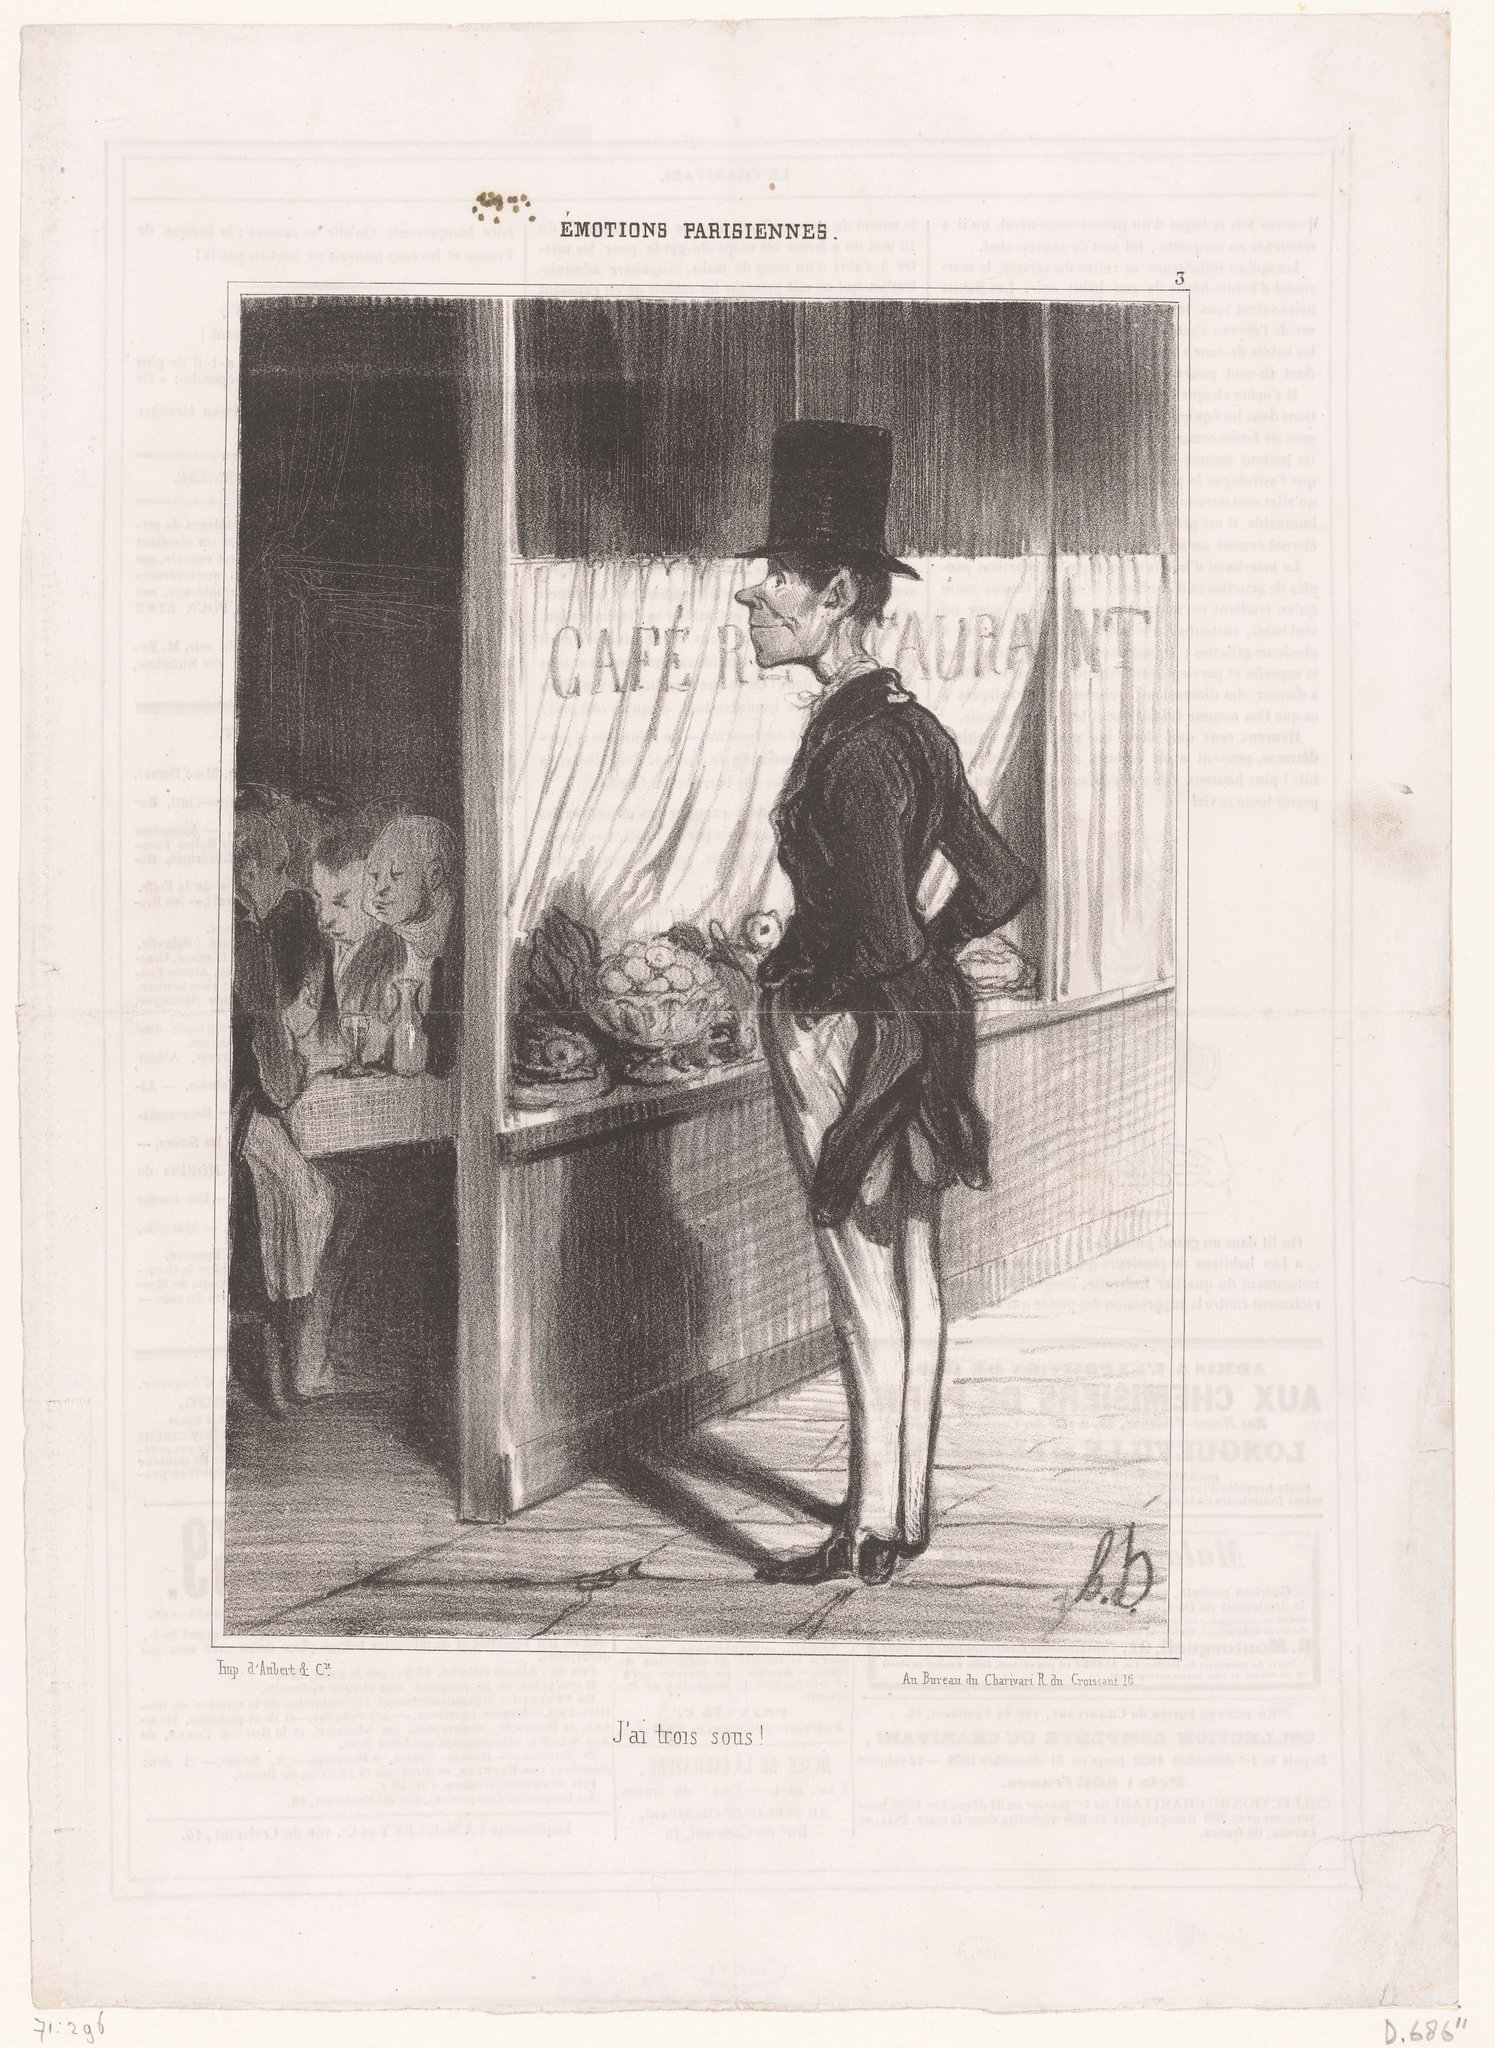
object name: cartoon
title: Émotions Parisiennes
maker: honoré daumier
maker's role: draughtsman, painter, print maker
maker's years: 1808-1879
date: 1839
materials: paper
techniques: letterpress printing, lithograph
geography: paris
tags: caricatures (human types), inn, coffee-house, public house, etc.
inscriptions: collector's mark: Lugt 2228a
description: Prent mogelijk uit: Le Charivari, 11 augustus 1839.